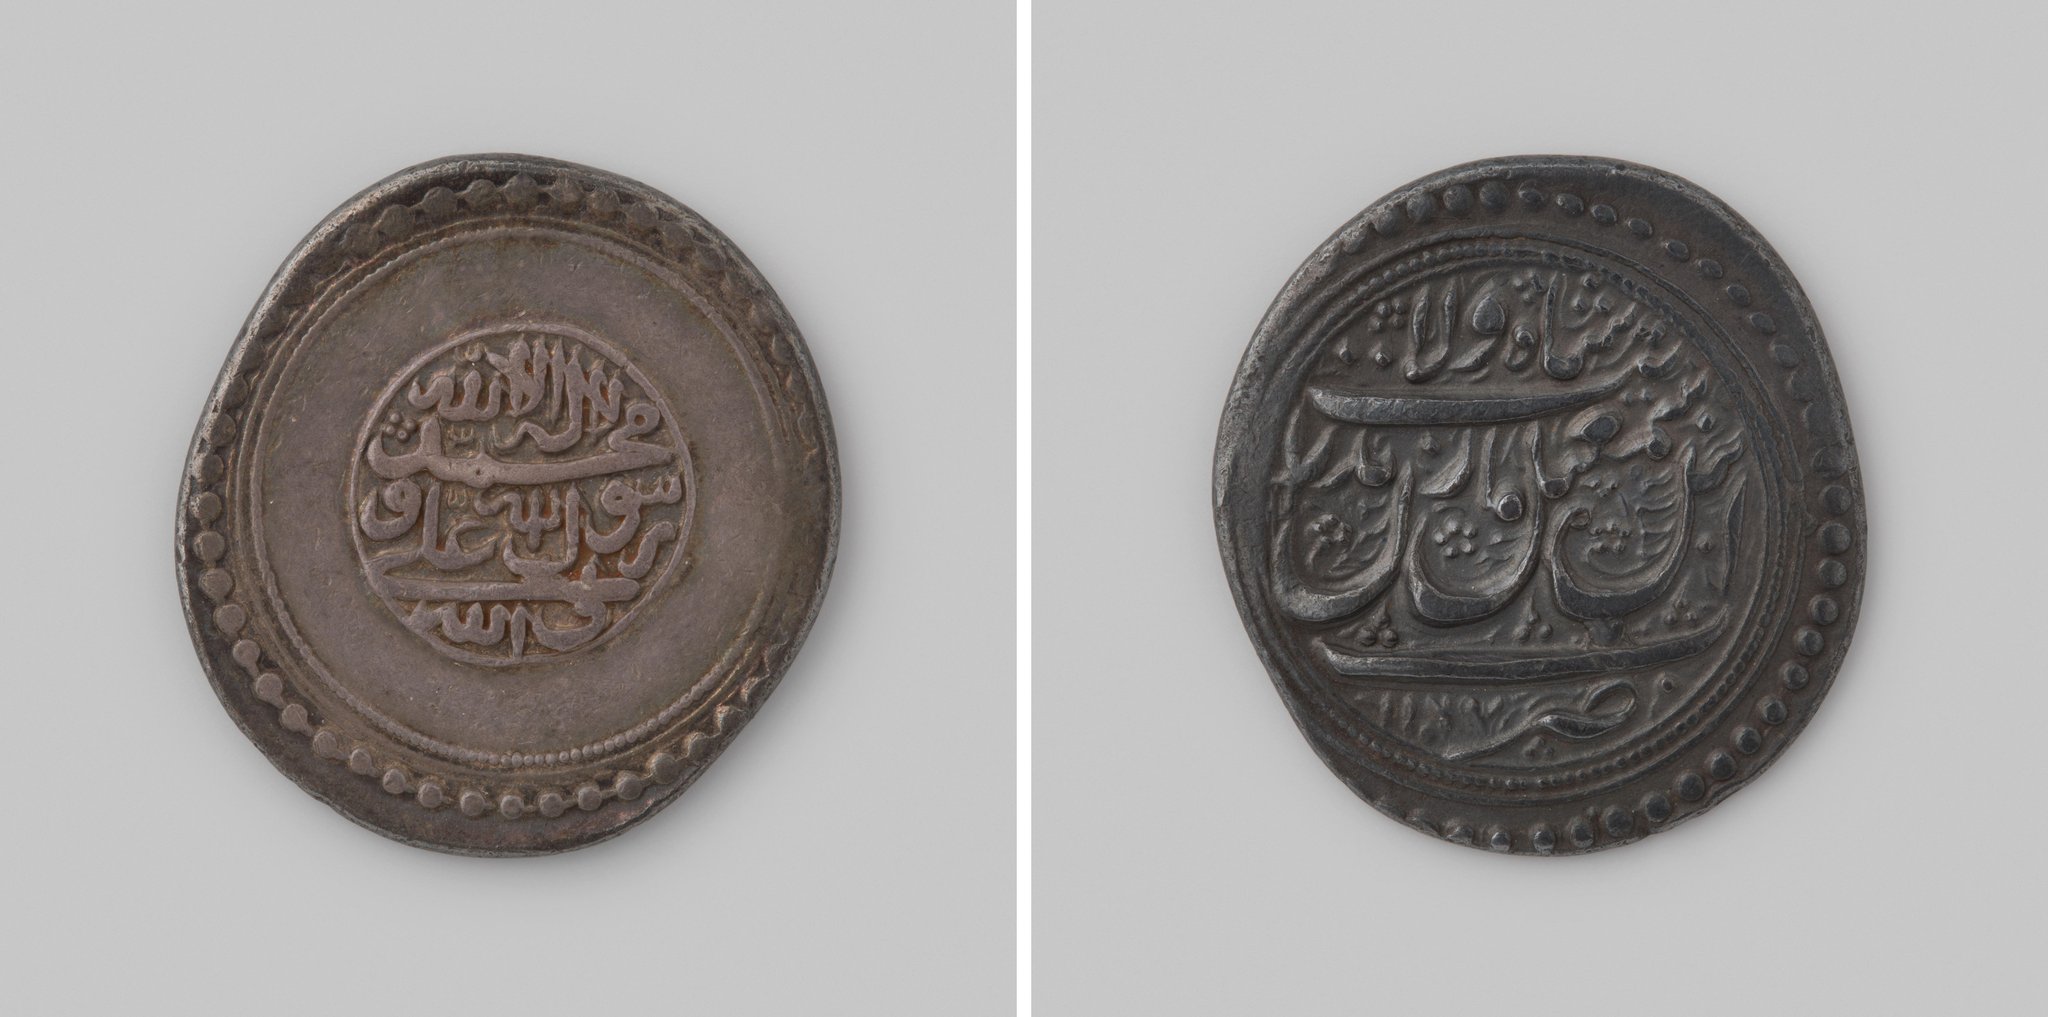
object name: coin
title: 10 shahi of rupi uit Perzië van Ismail III, 1163-1169 AH [=1750-1756], 1167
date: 1748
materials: silver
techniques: striking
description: Zilveren munt. Voorzijde: in Arabische lettertekens opschrift in twee regels, in linkergedeelte van tweede regel muntplaats-aanduiding: Mazandaran. Daaronder jaartal: 1167. Keerzijde: binnen cirkel in Arabische lettertekens Shiitische kalima [=geloofsbelijdenis] in drie regels. Rondom cirkel brede, gladde rand. Gladde rand.